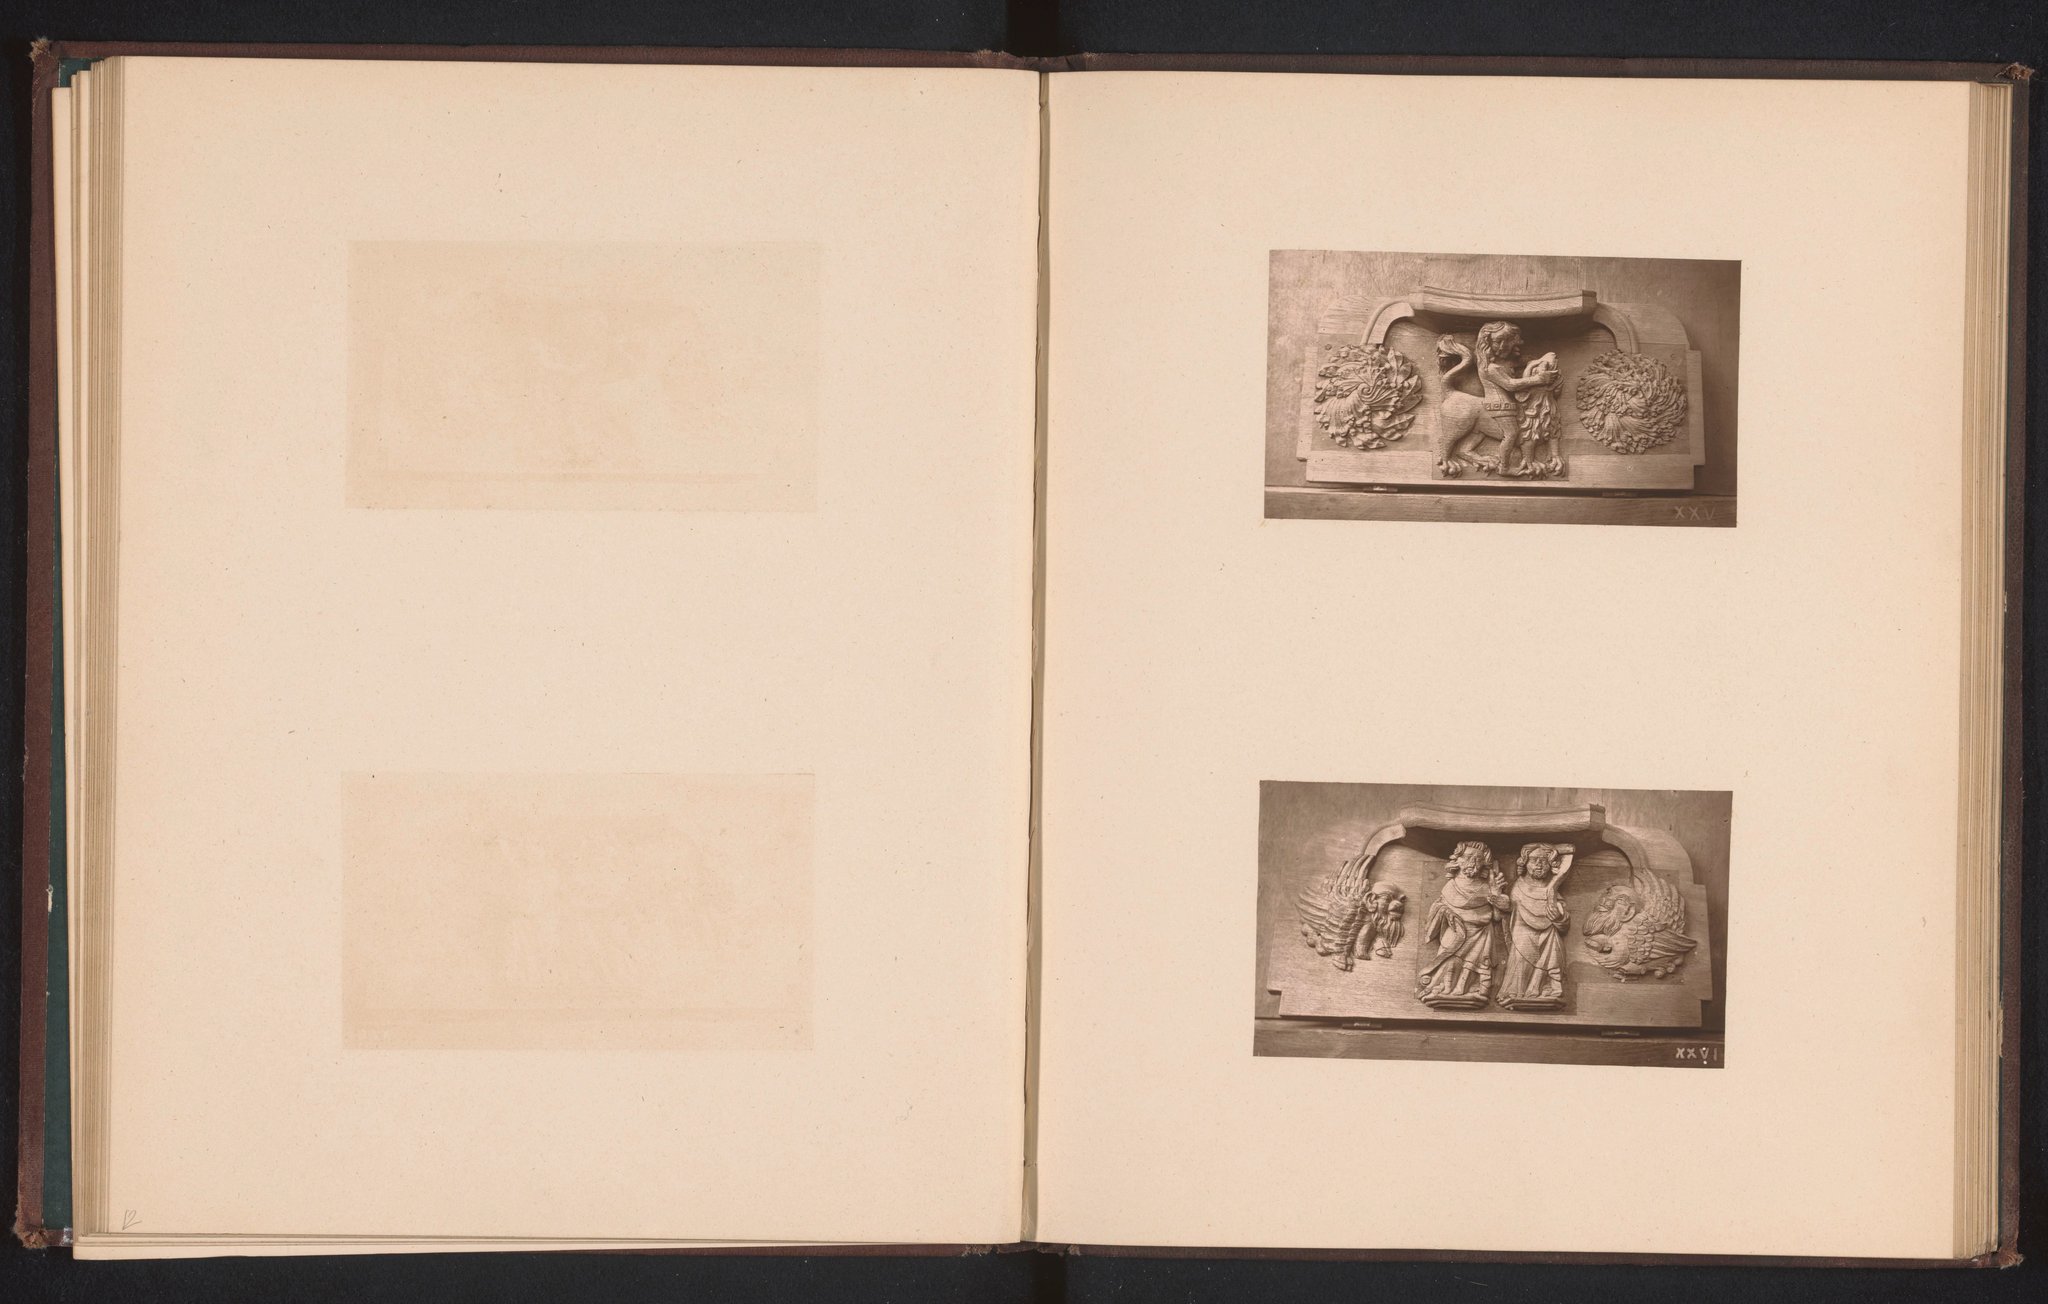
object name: page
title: Twee houtsnijwerken in de Kathedraal van Worcester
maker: Anonymous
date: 1863-1873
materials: paper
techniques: woodburytype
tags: carving ~ applied arts, interior of church, scroll, man struggling with animals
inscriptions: number: ‘XXV (...) XXVI’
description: Boven een figuur worstelt met een leeuw tussen twee bladmotieven, onder twee figuren met boekrollen tussen twee fantasiewezens.